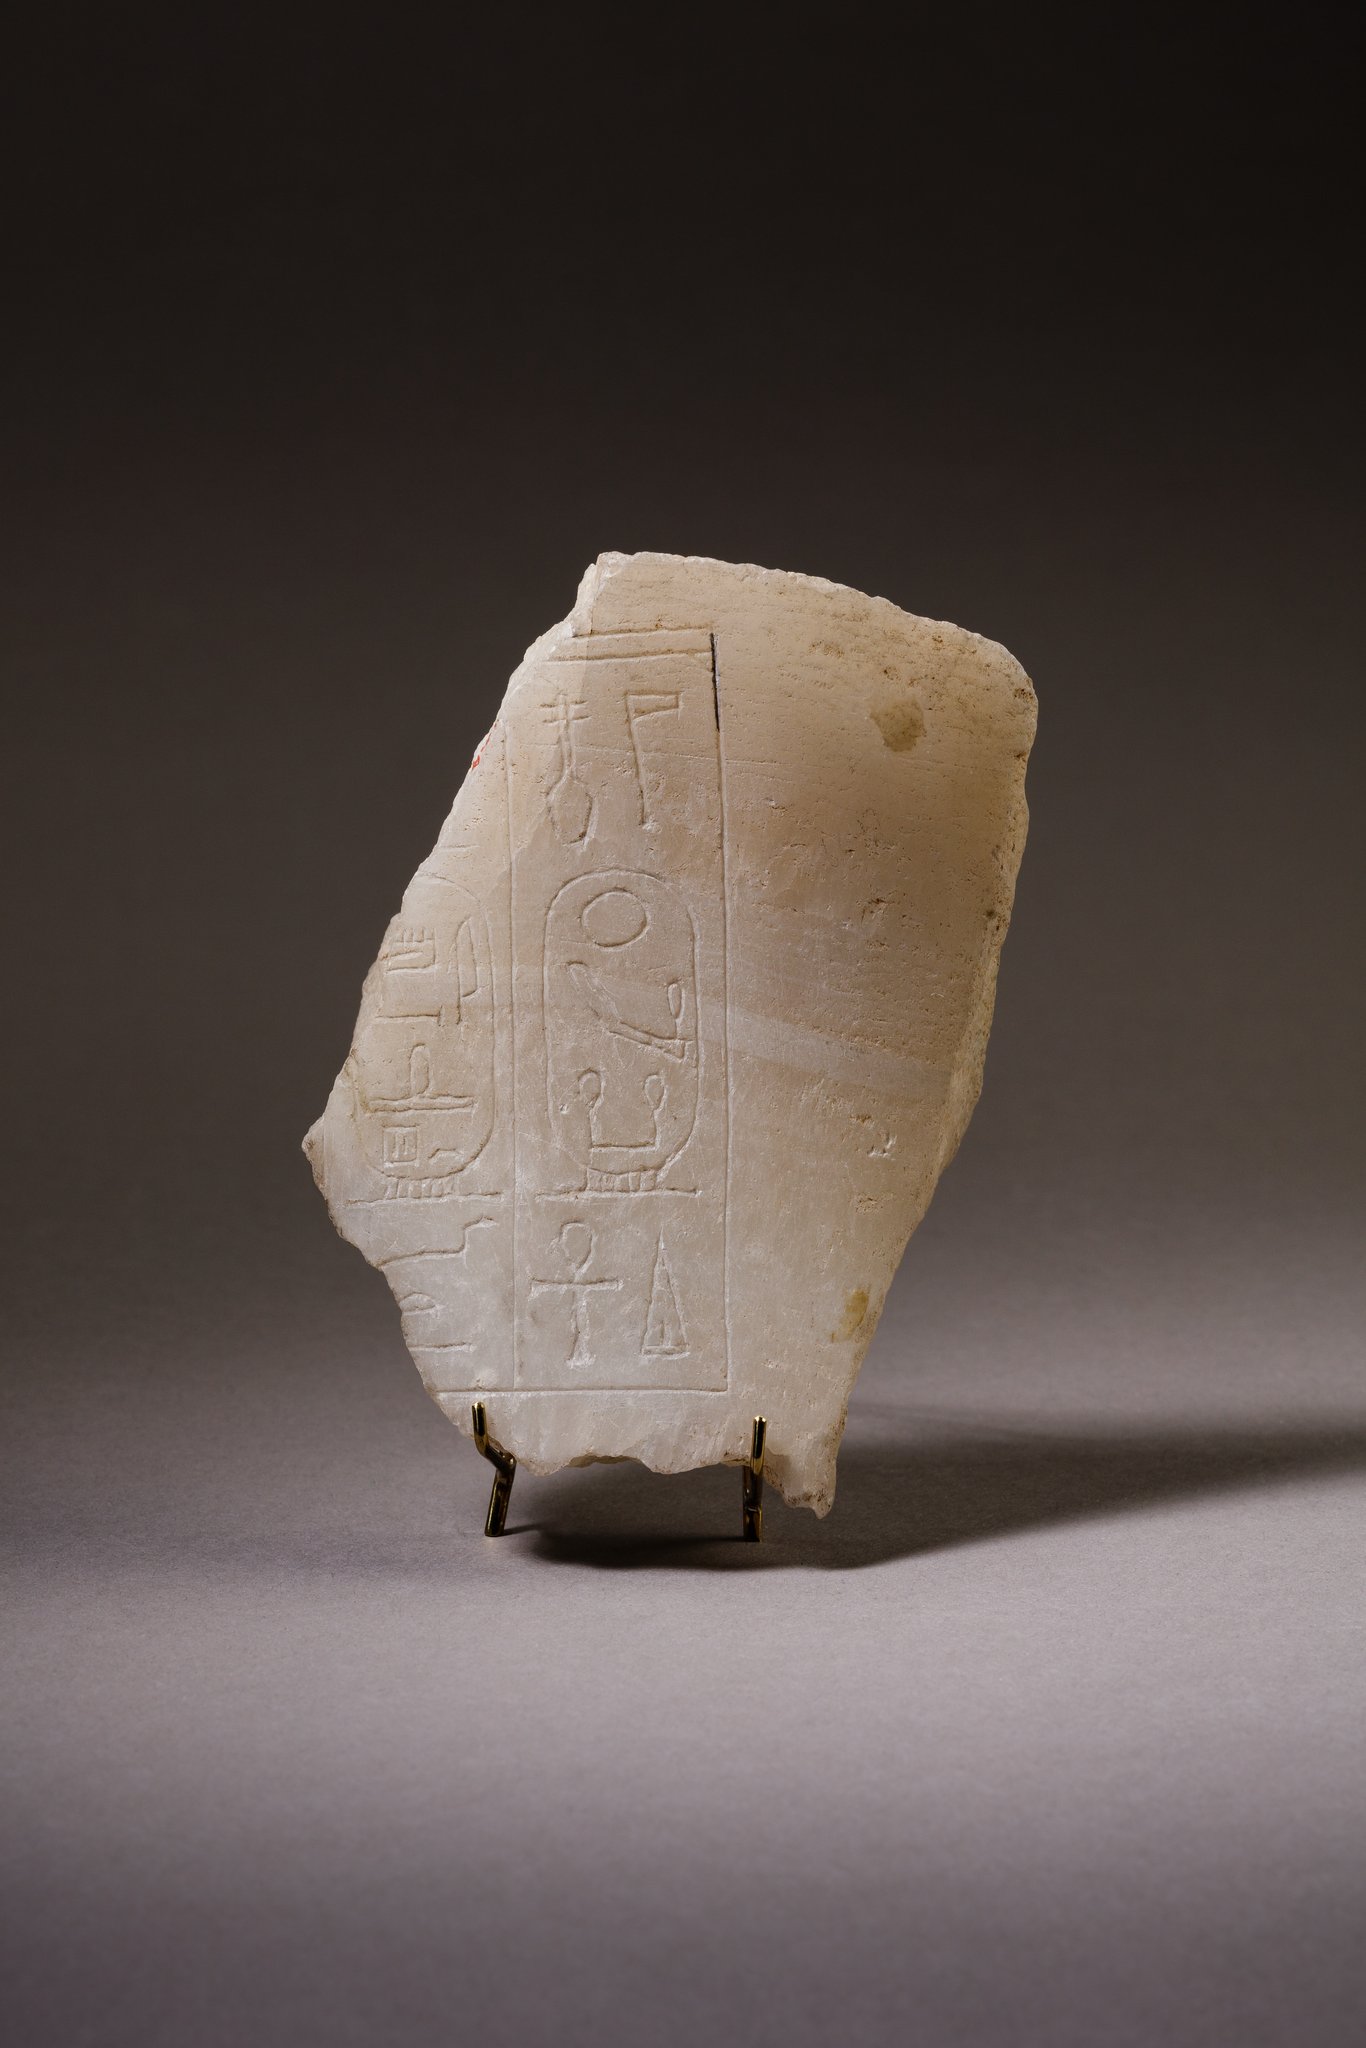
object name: jar fragment, amenhotep i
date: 1525-1504 BCE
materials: stone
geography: egypt